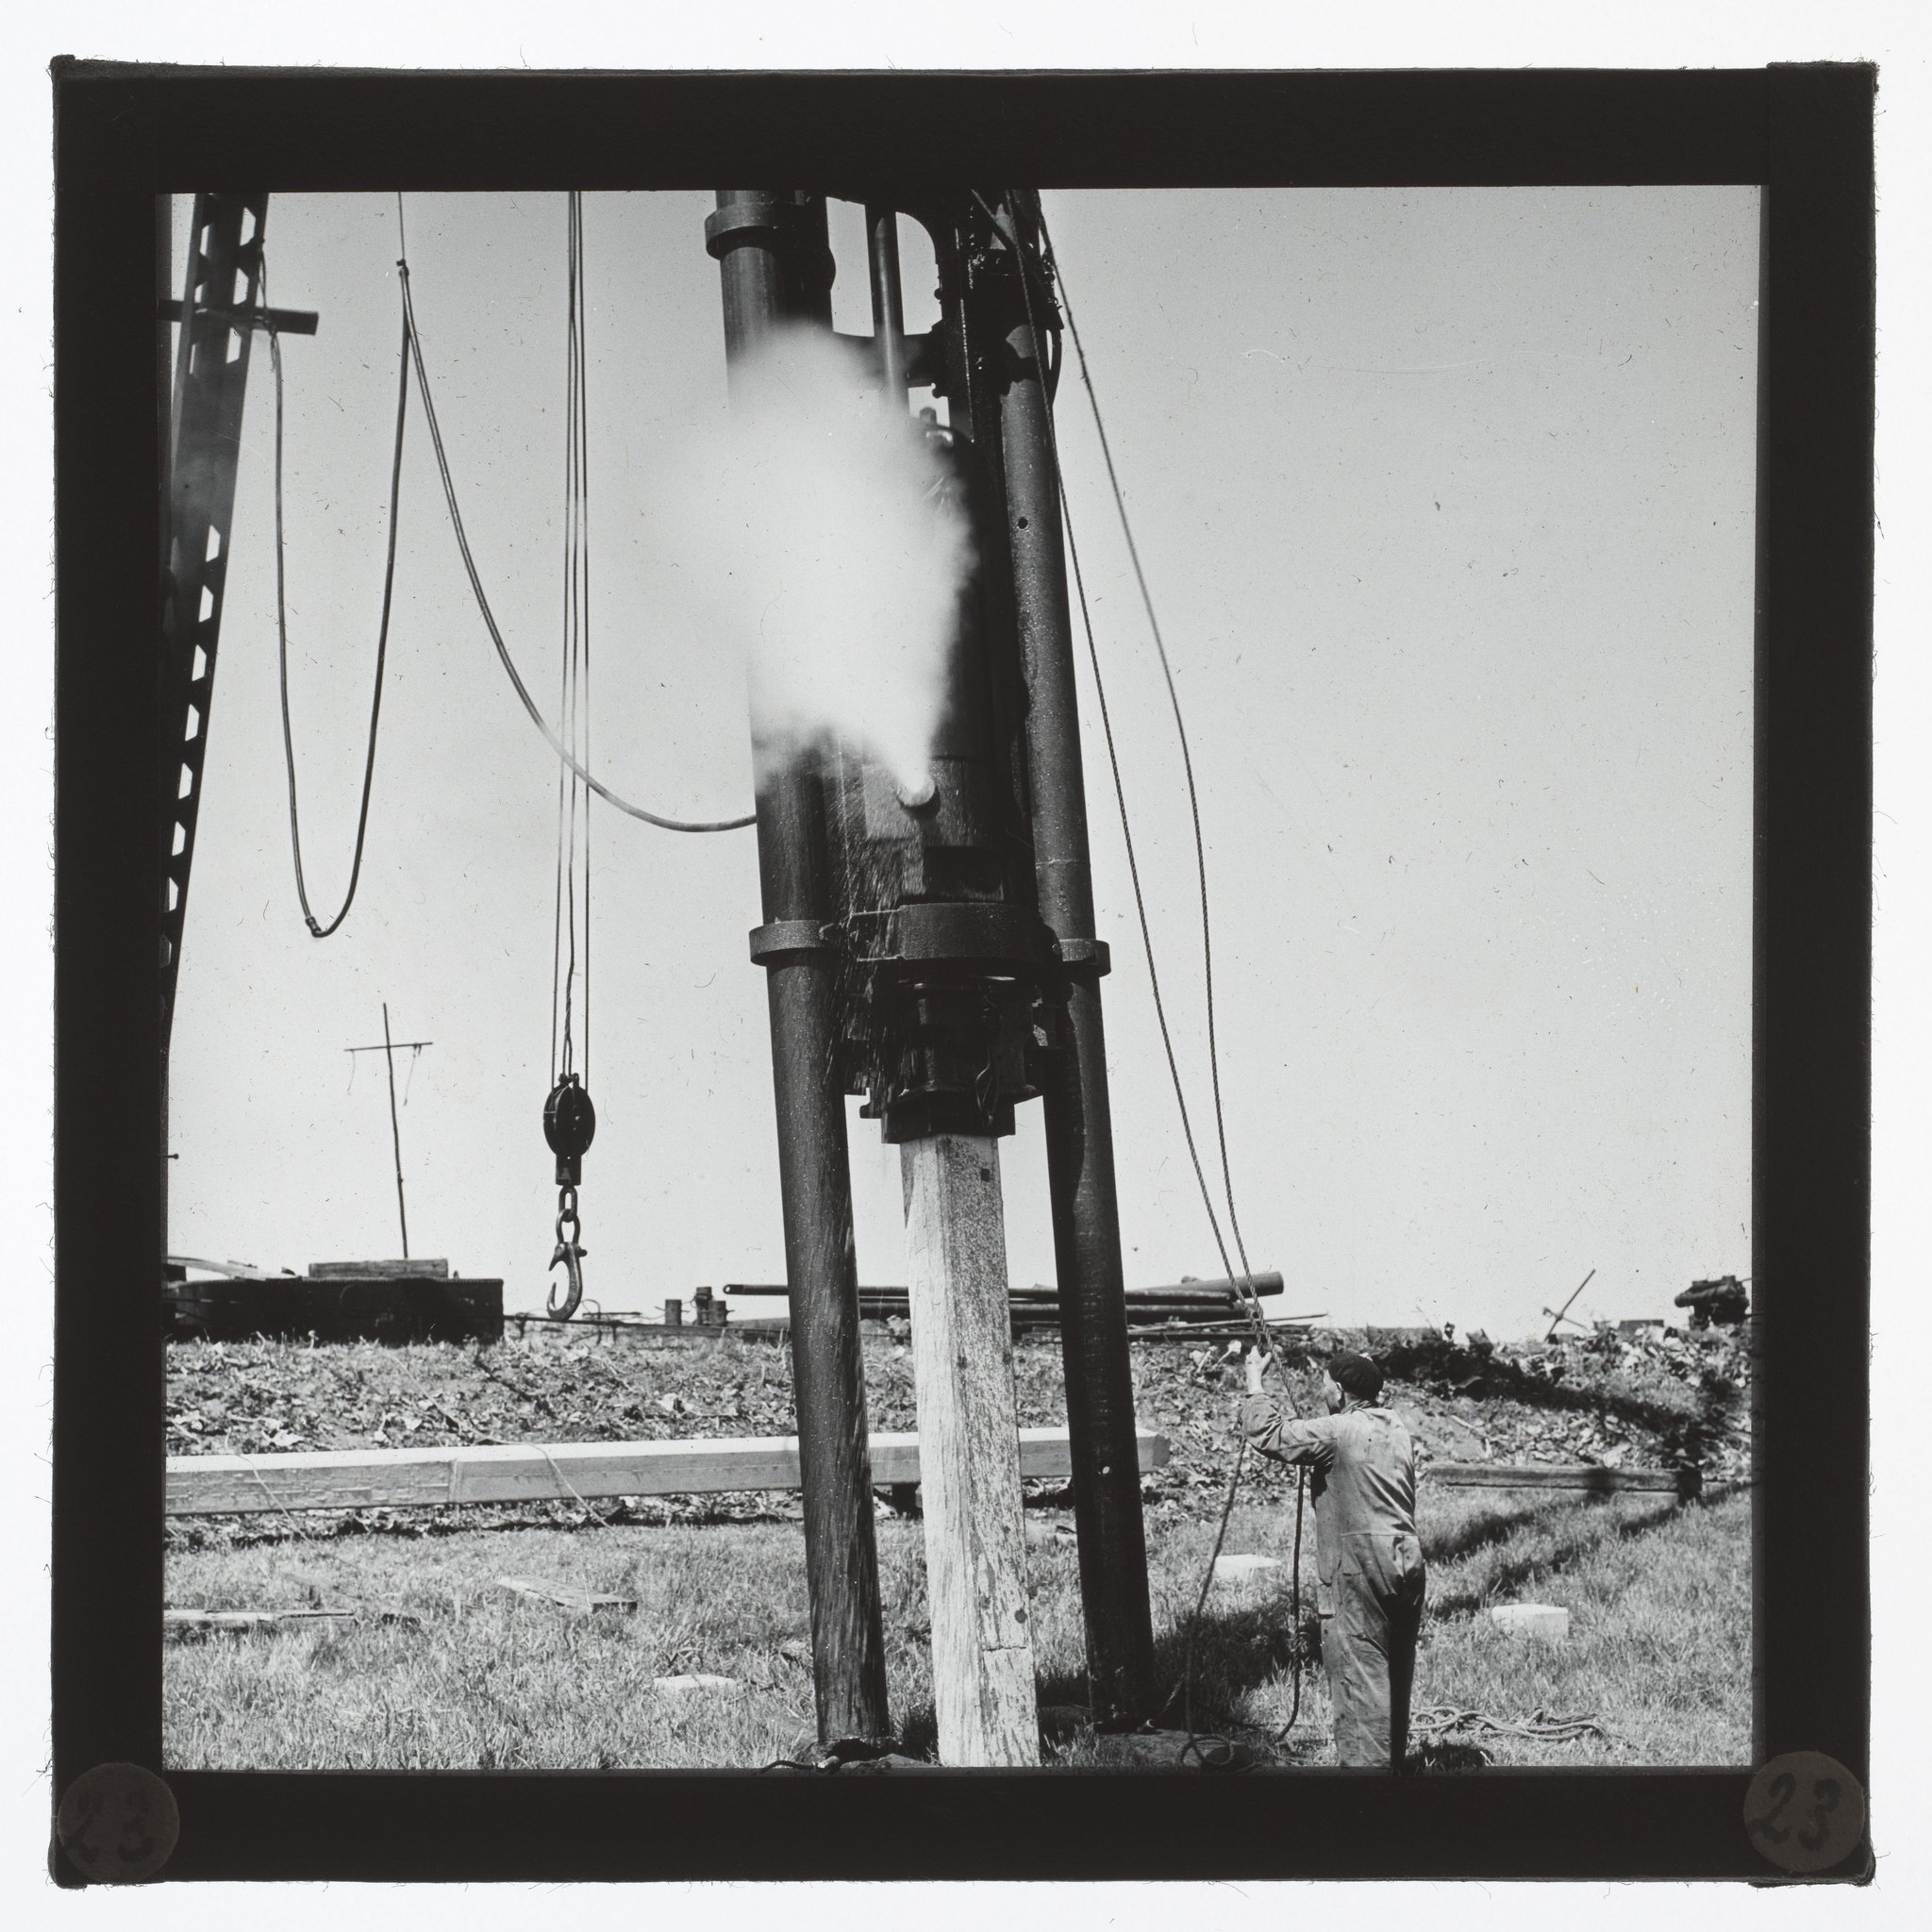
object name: lantern slide photographic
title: Heiwerkzaamheden, Zuid-Holland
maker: Anonymous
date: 1956-1960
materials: glass, paper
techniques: gelatin silver transparency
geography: south holland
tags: ramming, driving piles (~ building activities)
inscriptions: number: ‘23’